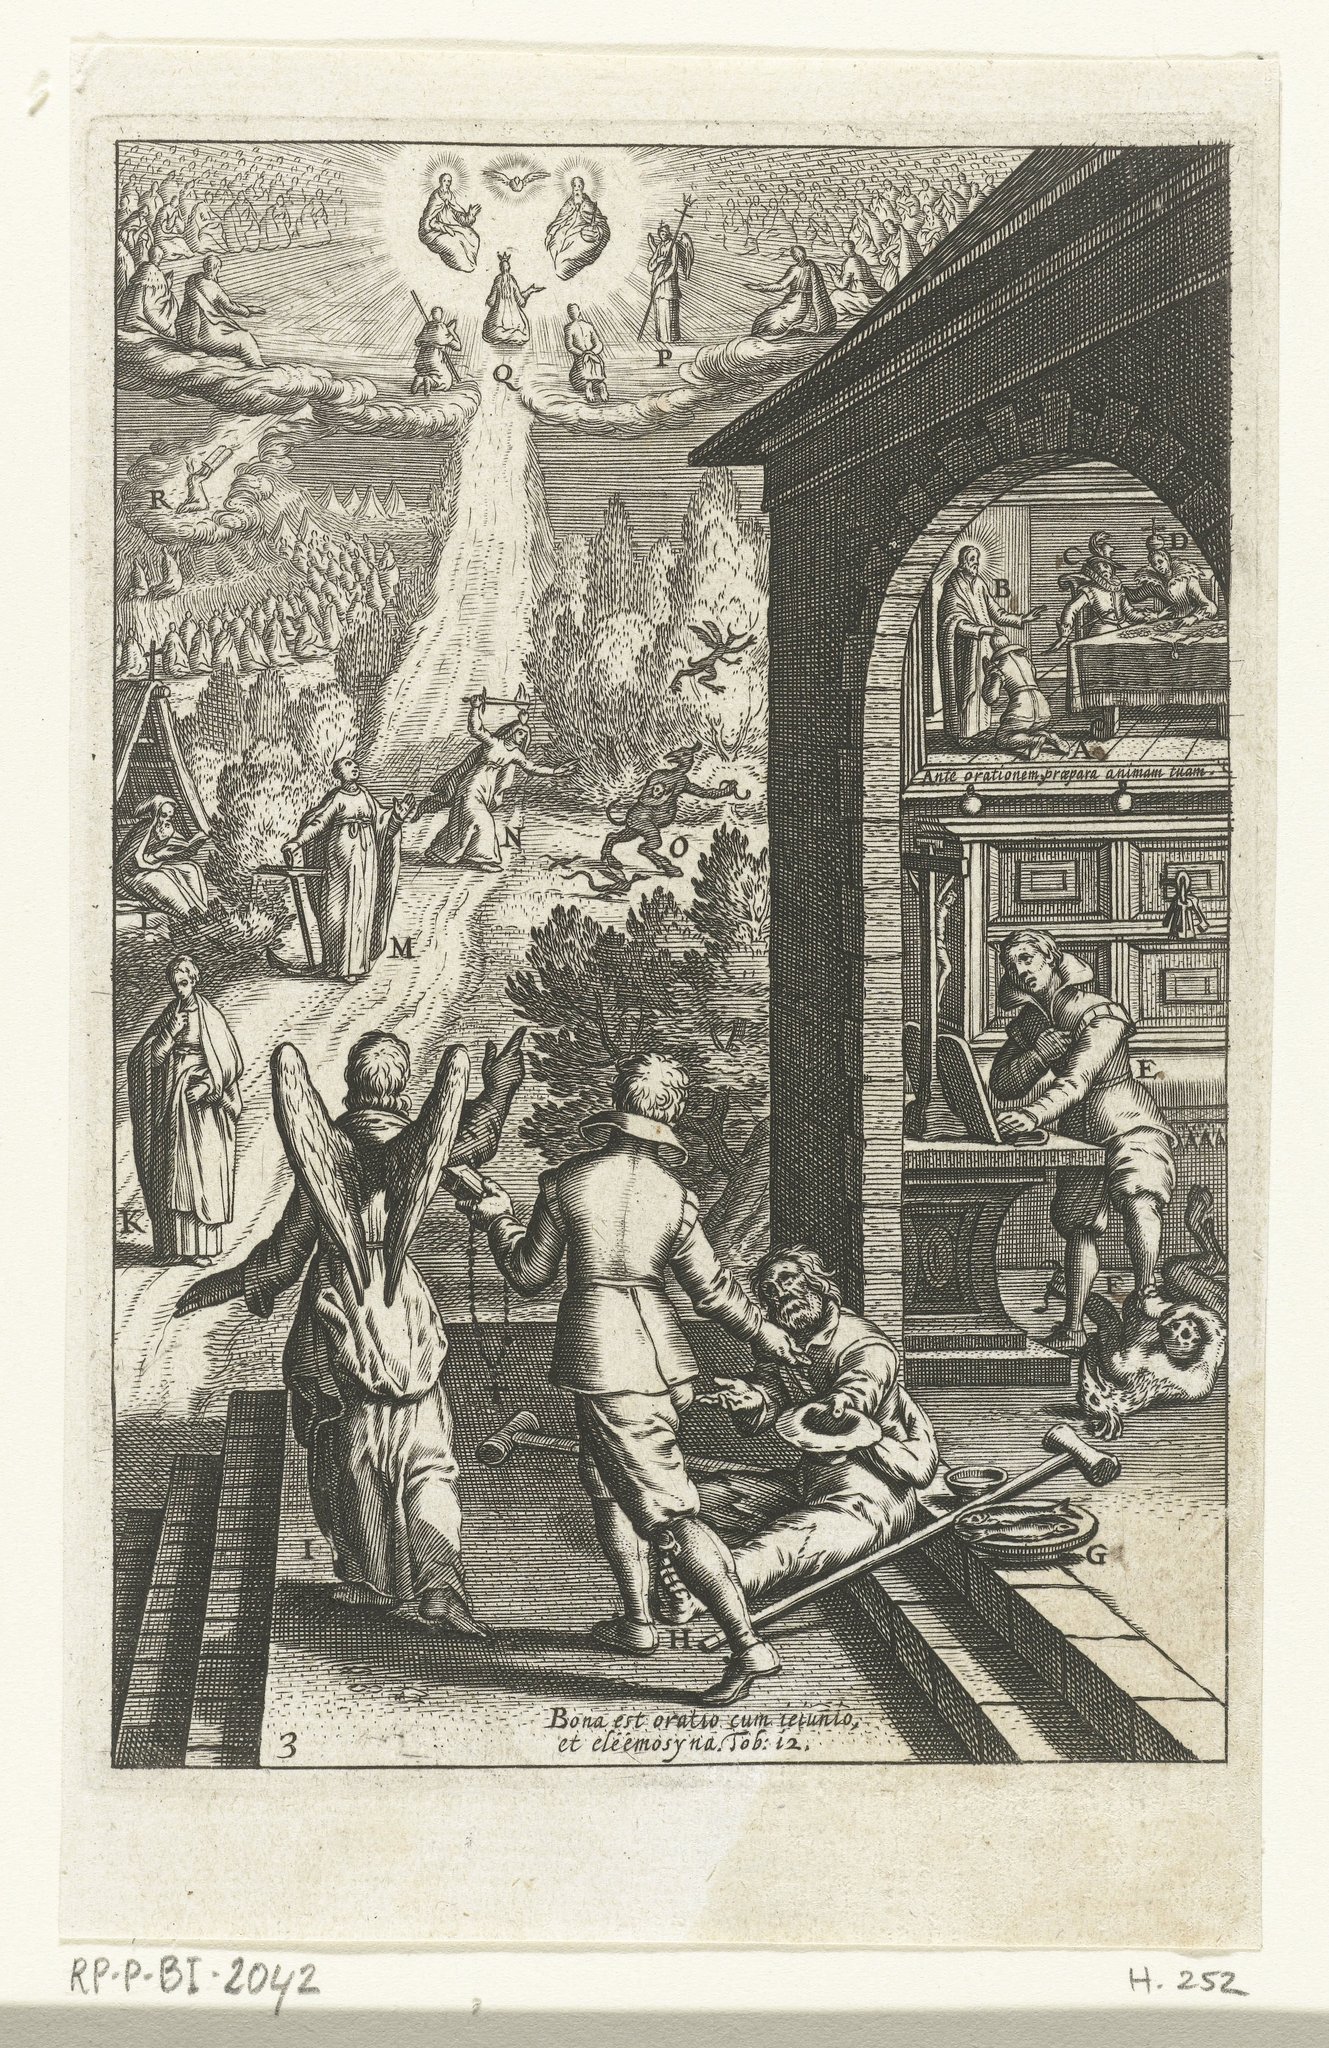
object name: print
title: Embleem met man die zich met goede daden voorbereidt op een gebed tot God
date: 1620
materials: paper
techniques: engraving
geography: antwerp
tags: giving alms or other charity, e.g.: handing out food, heaven represented in the air, with clouds (in concentric circles) and light, ecclesiastical books, scrolls, etc., aids for prayer, e.g. rosary, disabilities, deformations, guardian angel, (private) prayer; 'oratione', 'preghiere', 'preghiere a dio' (ripa), beggar, the life of man, the believer, journey to heaven, pathway to heaven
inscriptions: collector's mark: Lugt 2228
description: Een man met bijbel en rozenkrans in de hand volgt een engel die wijst naar een verschijning van God in de hemel. De man geeft geld aan een bedelaar die naast zijn krukken op de grond zit. Een korte Latijnse tekst verwijst naar Tobit 12:8a: 'Bidden [I] is iets goeds als het gepaard gaat met vasten [G], liefdadigheid [H]'.